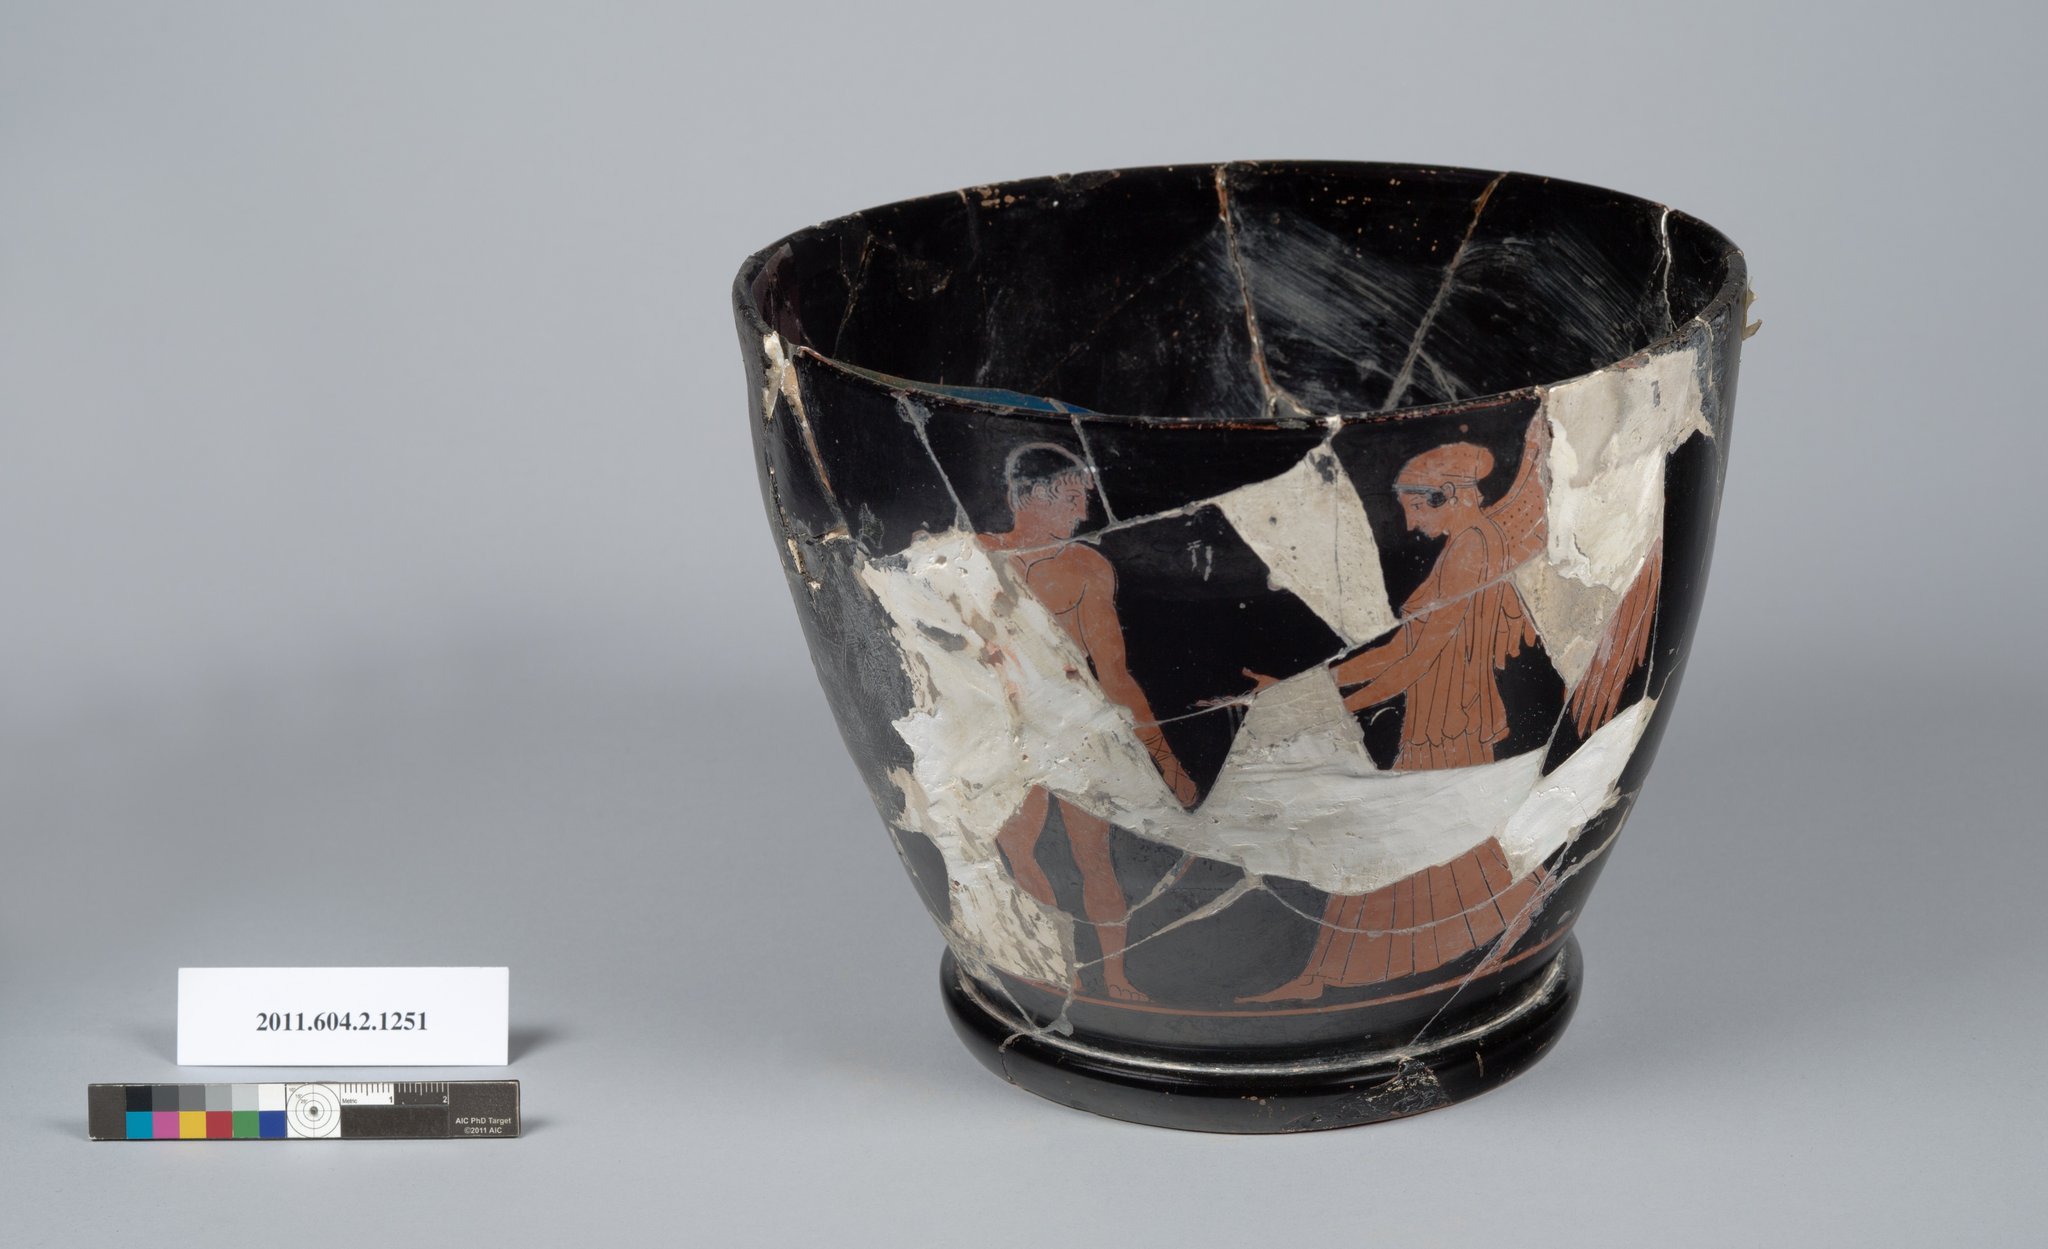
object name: skyphos fragment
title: Terracotta fragment of a skyphos (deep drinking cup)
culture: greek, attic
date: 460-450 BCE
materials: terracotta